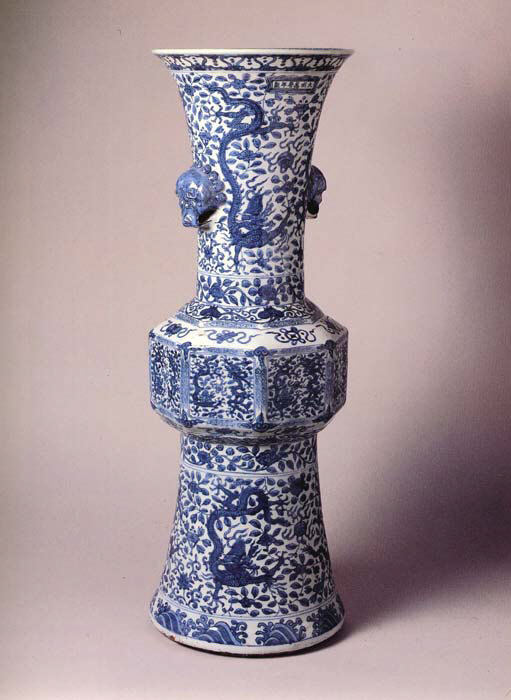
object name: vase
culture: chinese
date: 1573-1620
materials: porcelain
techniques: painting, underglaze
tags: dragons